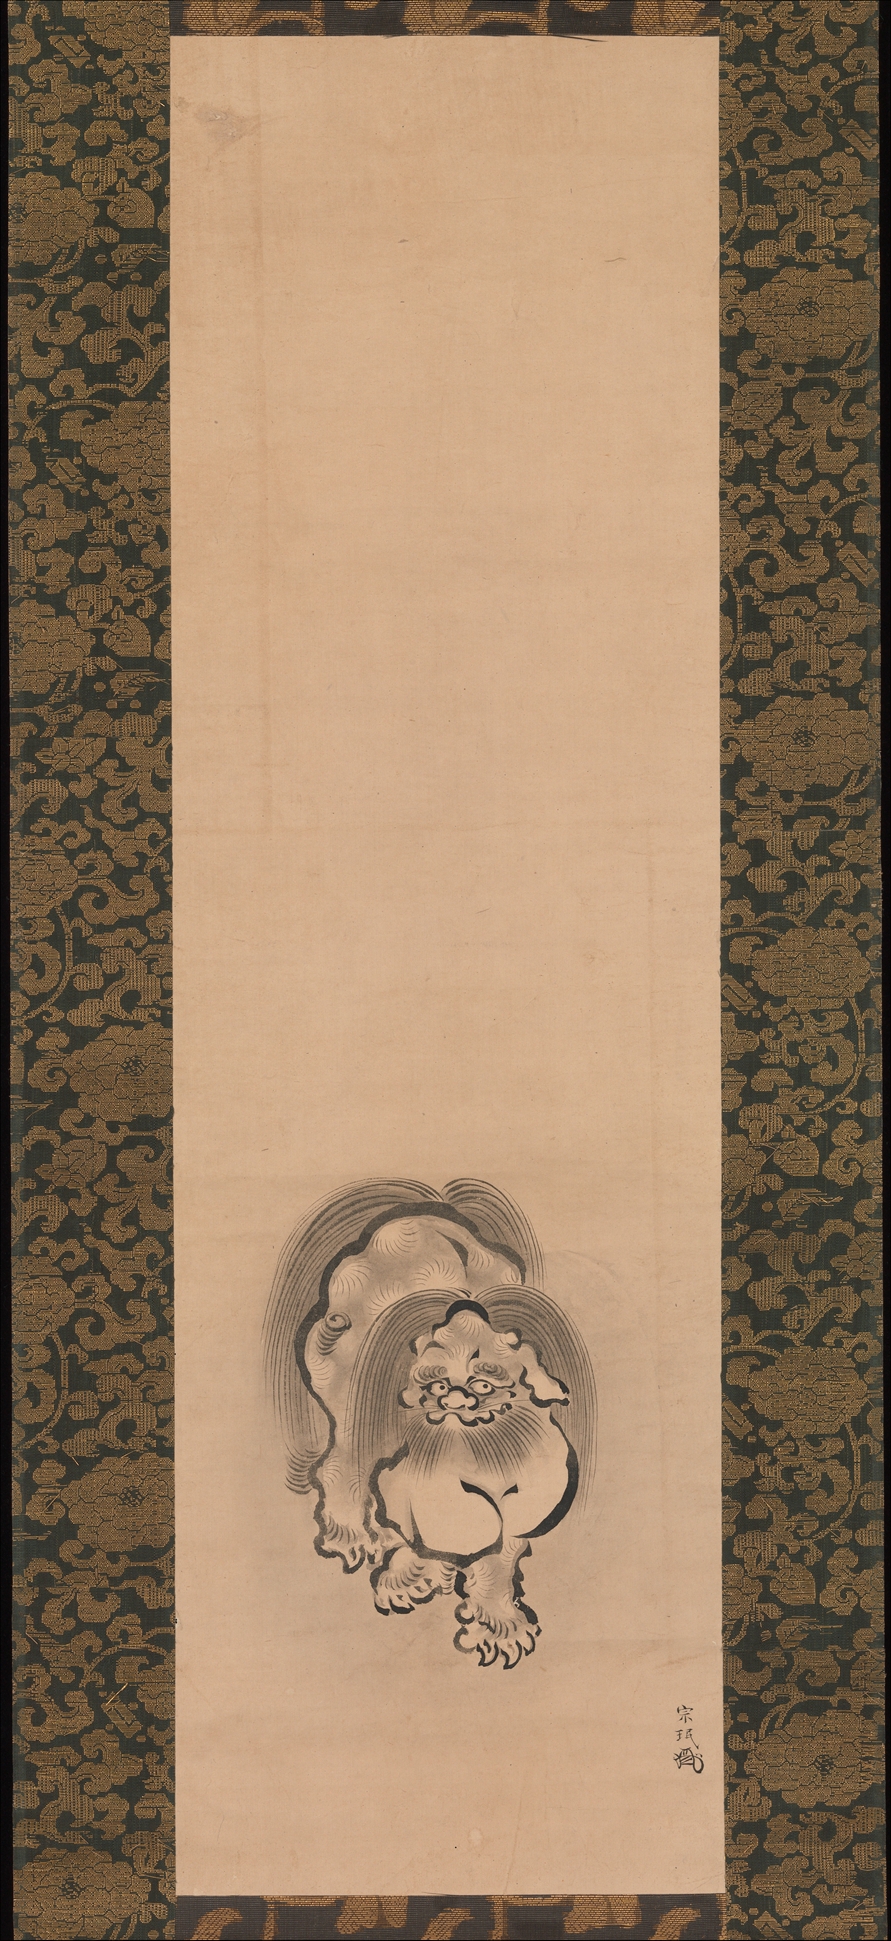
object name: hanging scroll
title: Chinese Lion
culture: japanese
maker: yokoya sōmin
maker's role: artist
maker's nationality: japanese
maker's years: 1669-1733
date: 1701-1733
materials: ink, paper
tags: lions